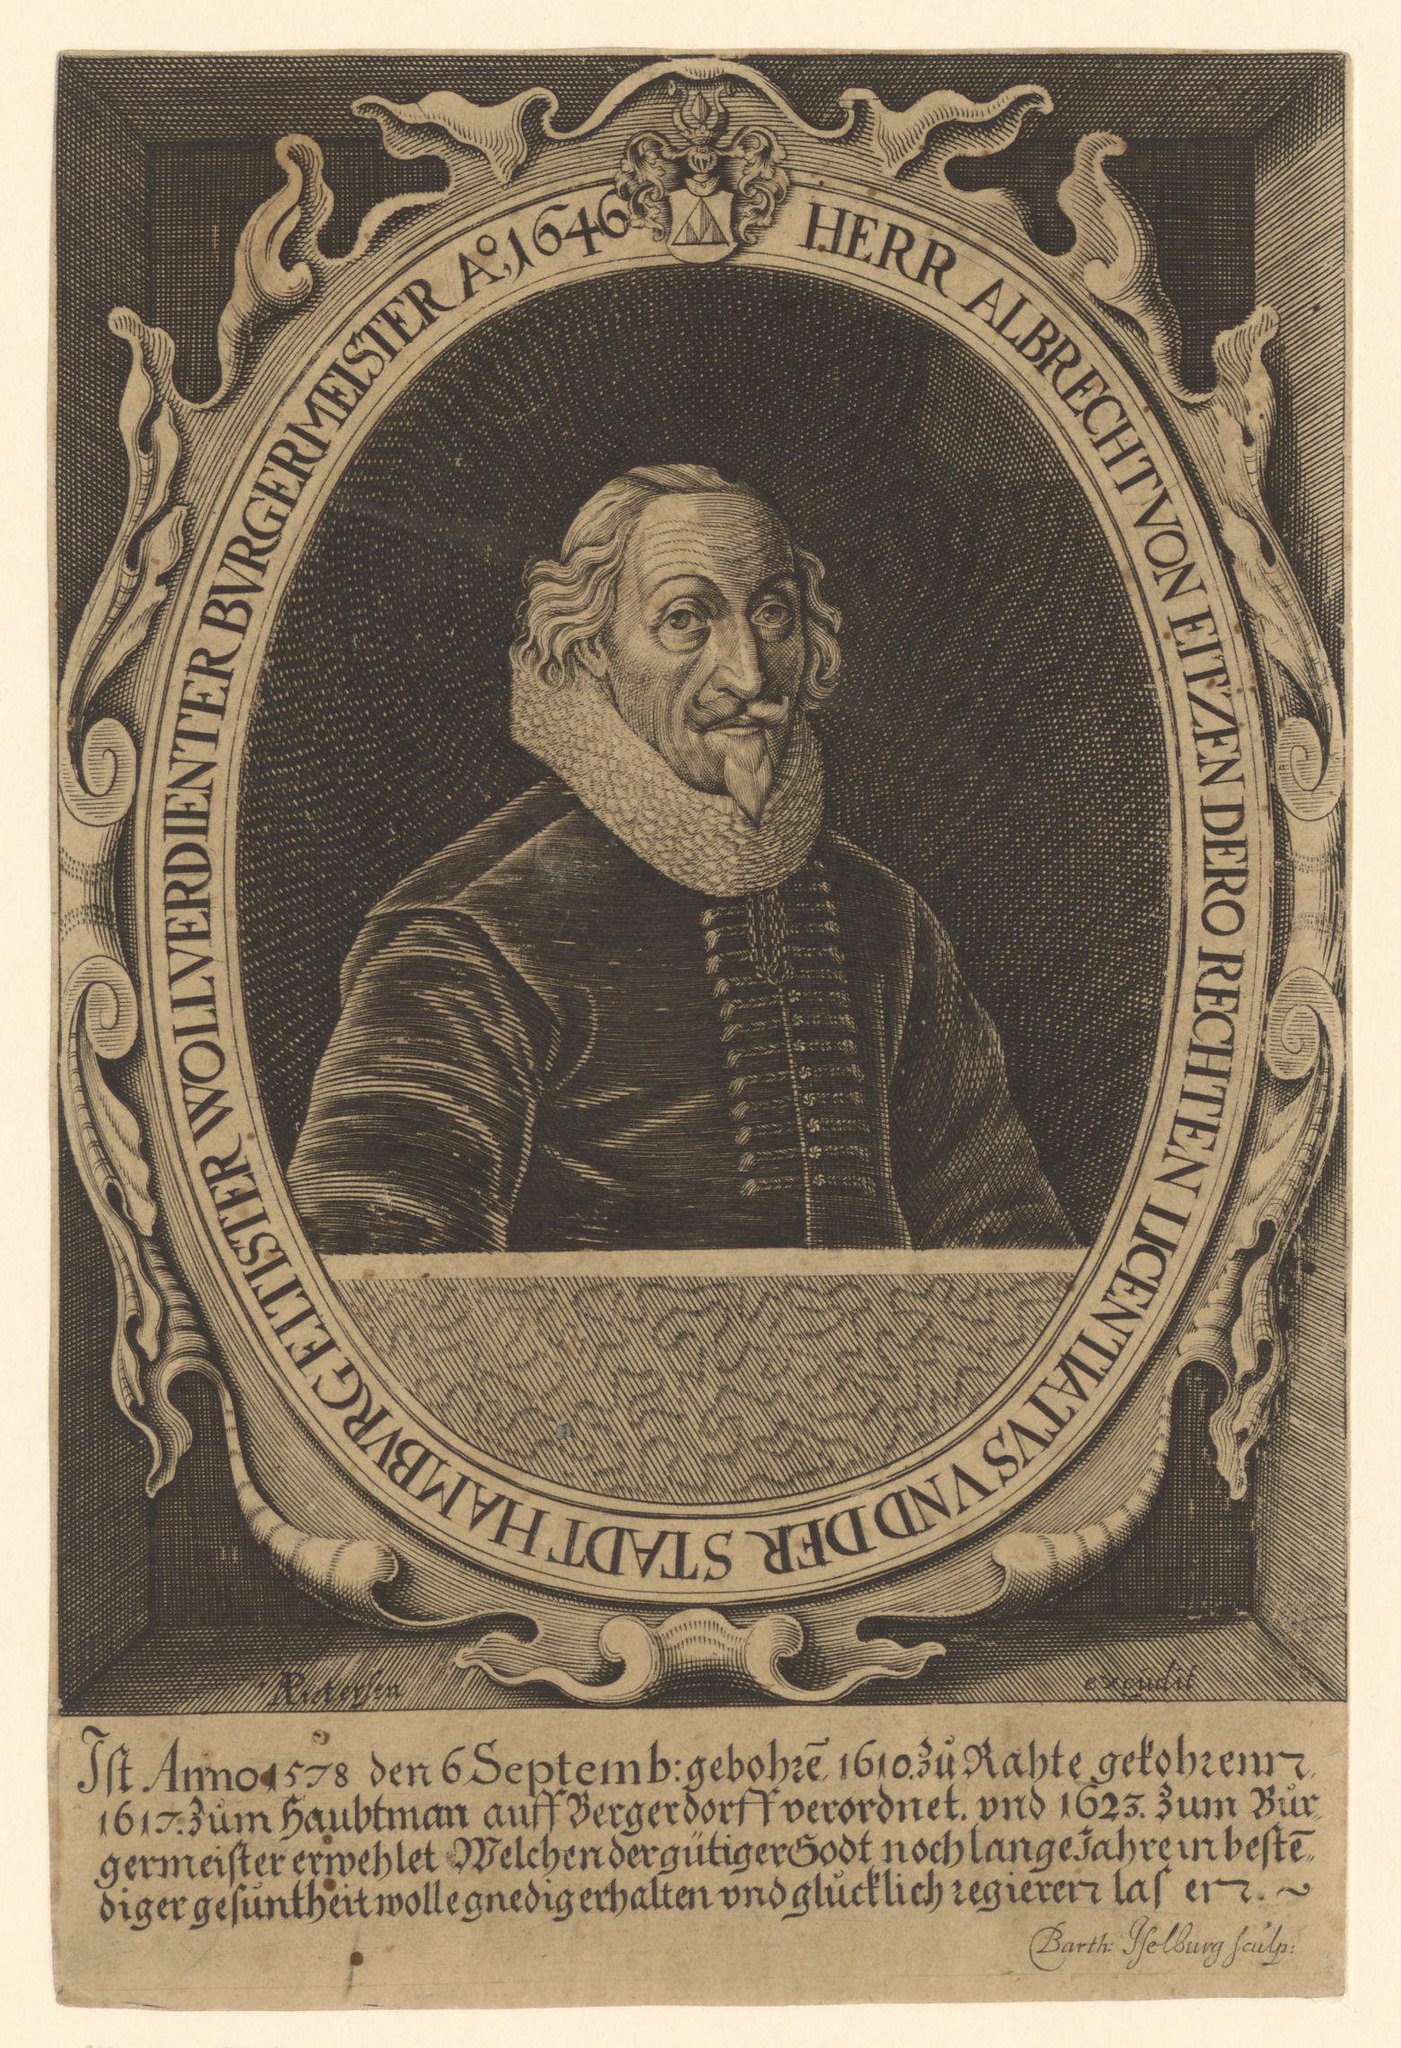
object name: print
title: Portret van Albrecht von Eitzen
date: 1628-1658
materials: paper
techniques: engraving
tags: mayor, mayor, burgomaster, historical persons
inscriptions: collector's mark: Lugt 2228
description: Portret in ovale medaillon. In de omlijsting en de marge eronder tekst in het Latijn.